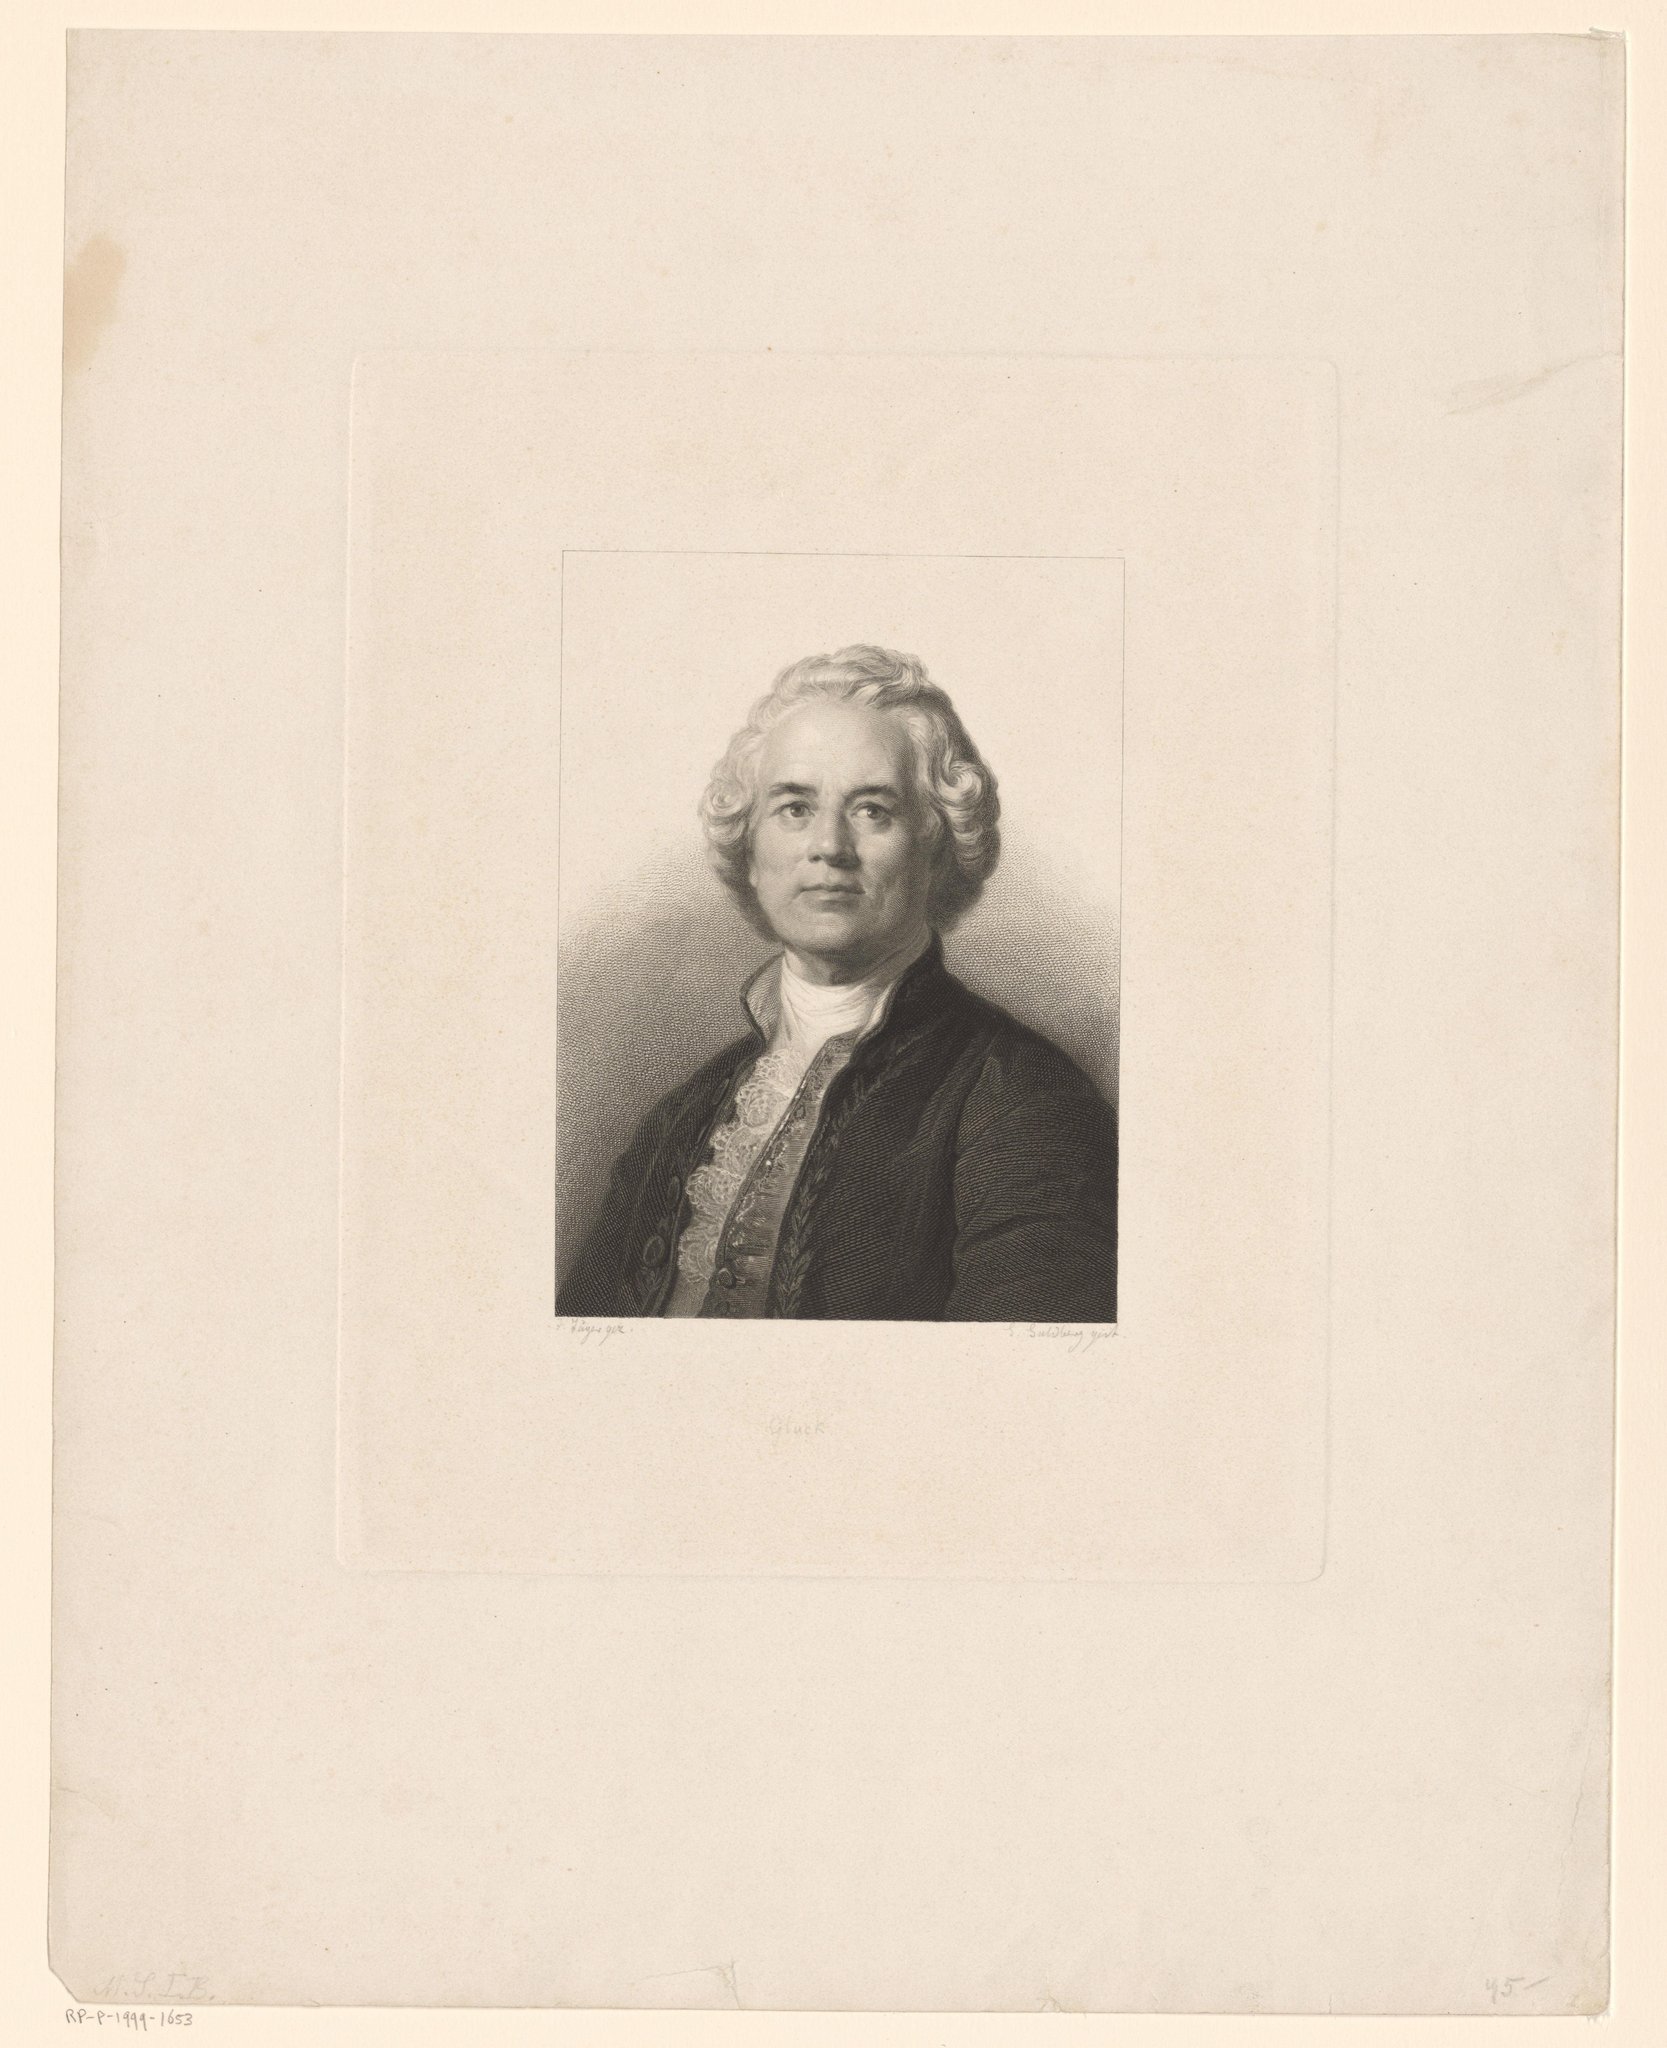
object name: print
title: Portret van Christoph Willibald von Gluck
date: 1843-1894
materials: paper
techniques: engraving, etching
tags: vienna, christoph willibald von gluck, historical persons, portrait of composer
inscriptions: collector's mark: Lugt 2228, collector's mark: Lugt 4099, collector's mark: Lugt 2760